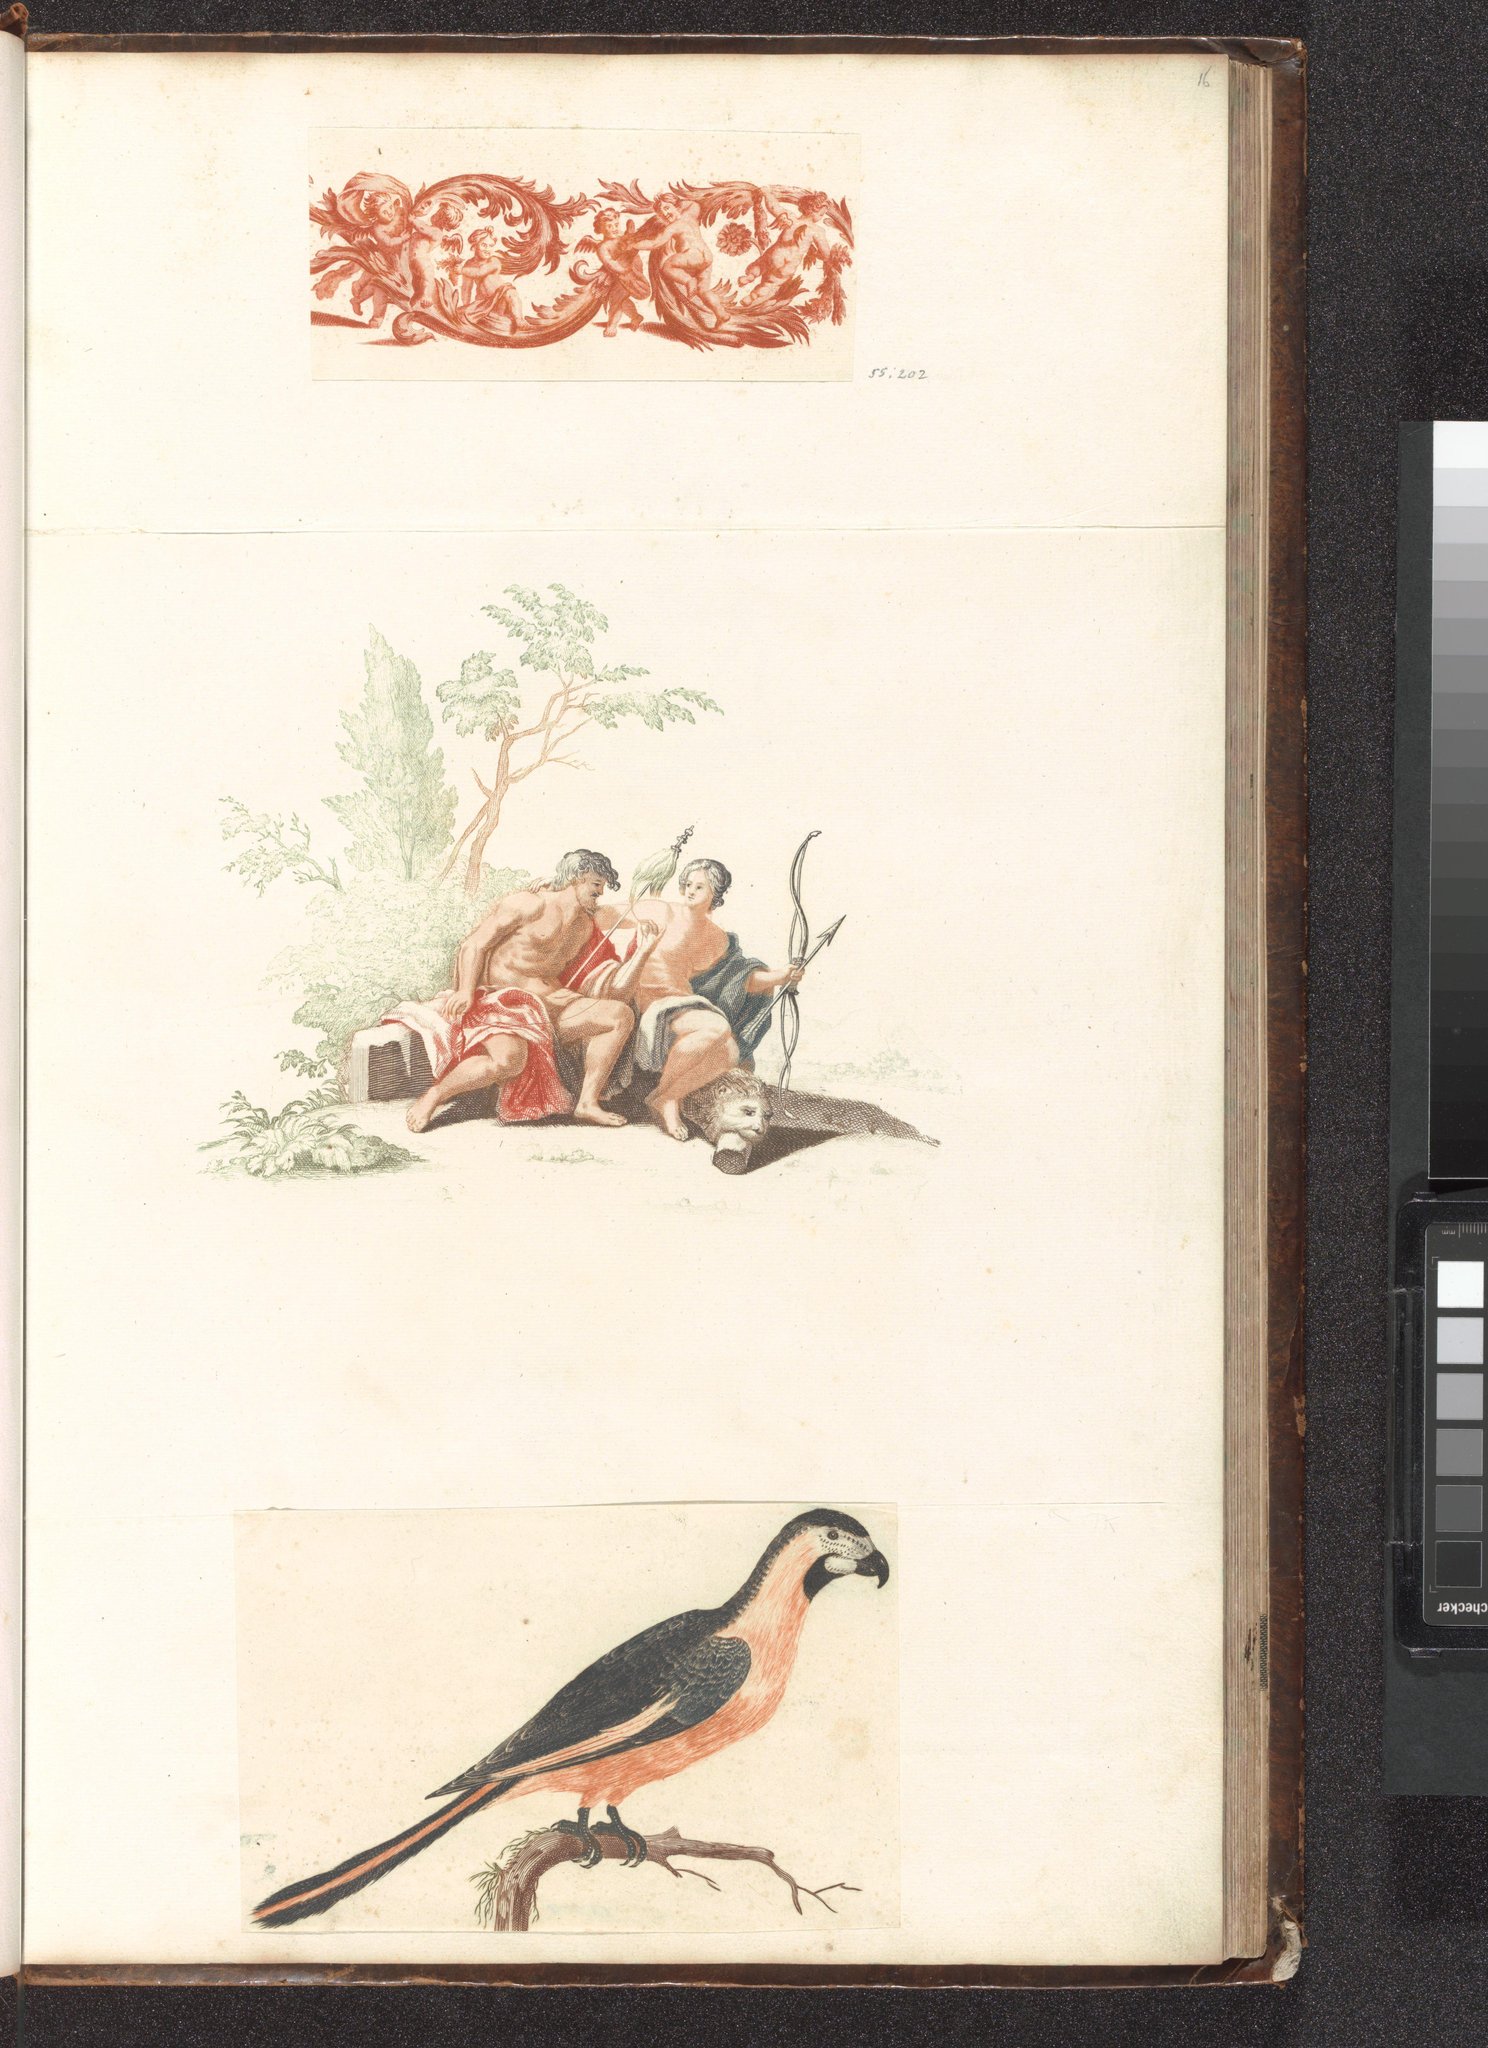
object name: album leaf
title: Bladornament met putti (rechter deel)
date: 1688-1698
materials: paper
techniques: printing, engraving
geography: netherlands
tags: foliage, tendrils, branches ~ ornament, cupids: 'amores', 'amoretti', 'putti'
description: Ornamentele bladmotieven met putti. Deze prent maakt deel uit van een album.